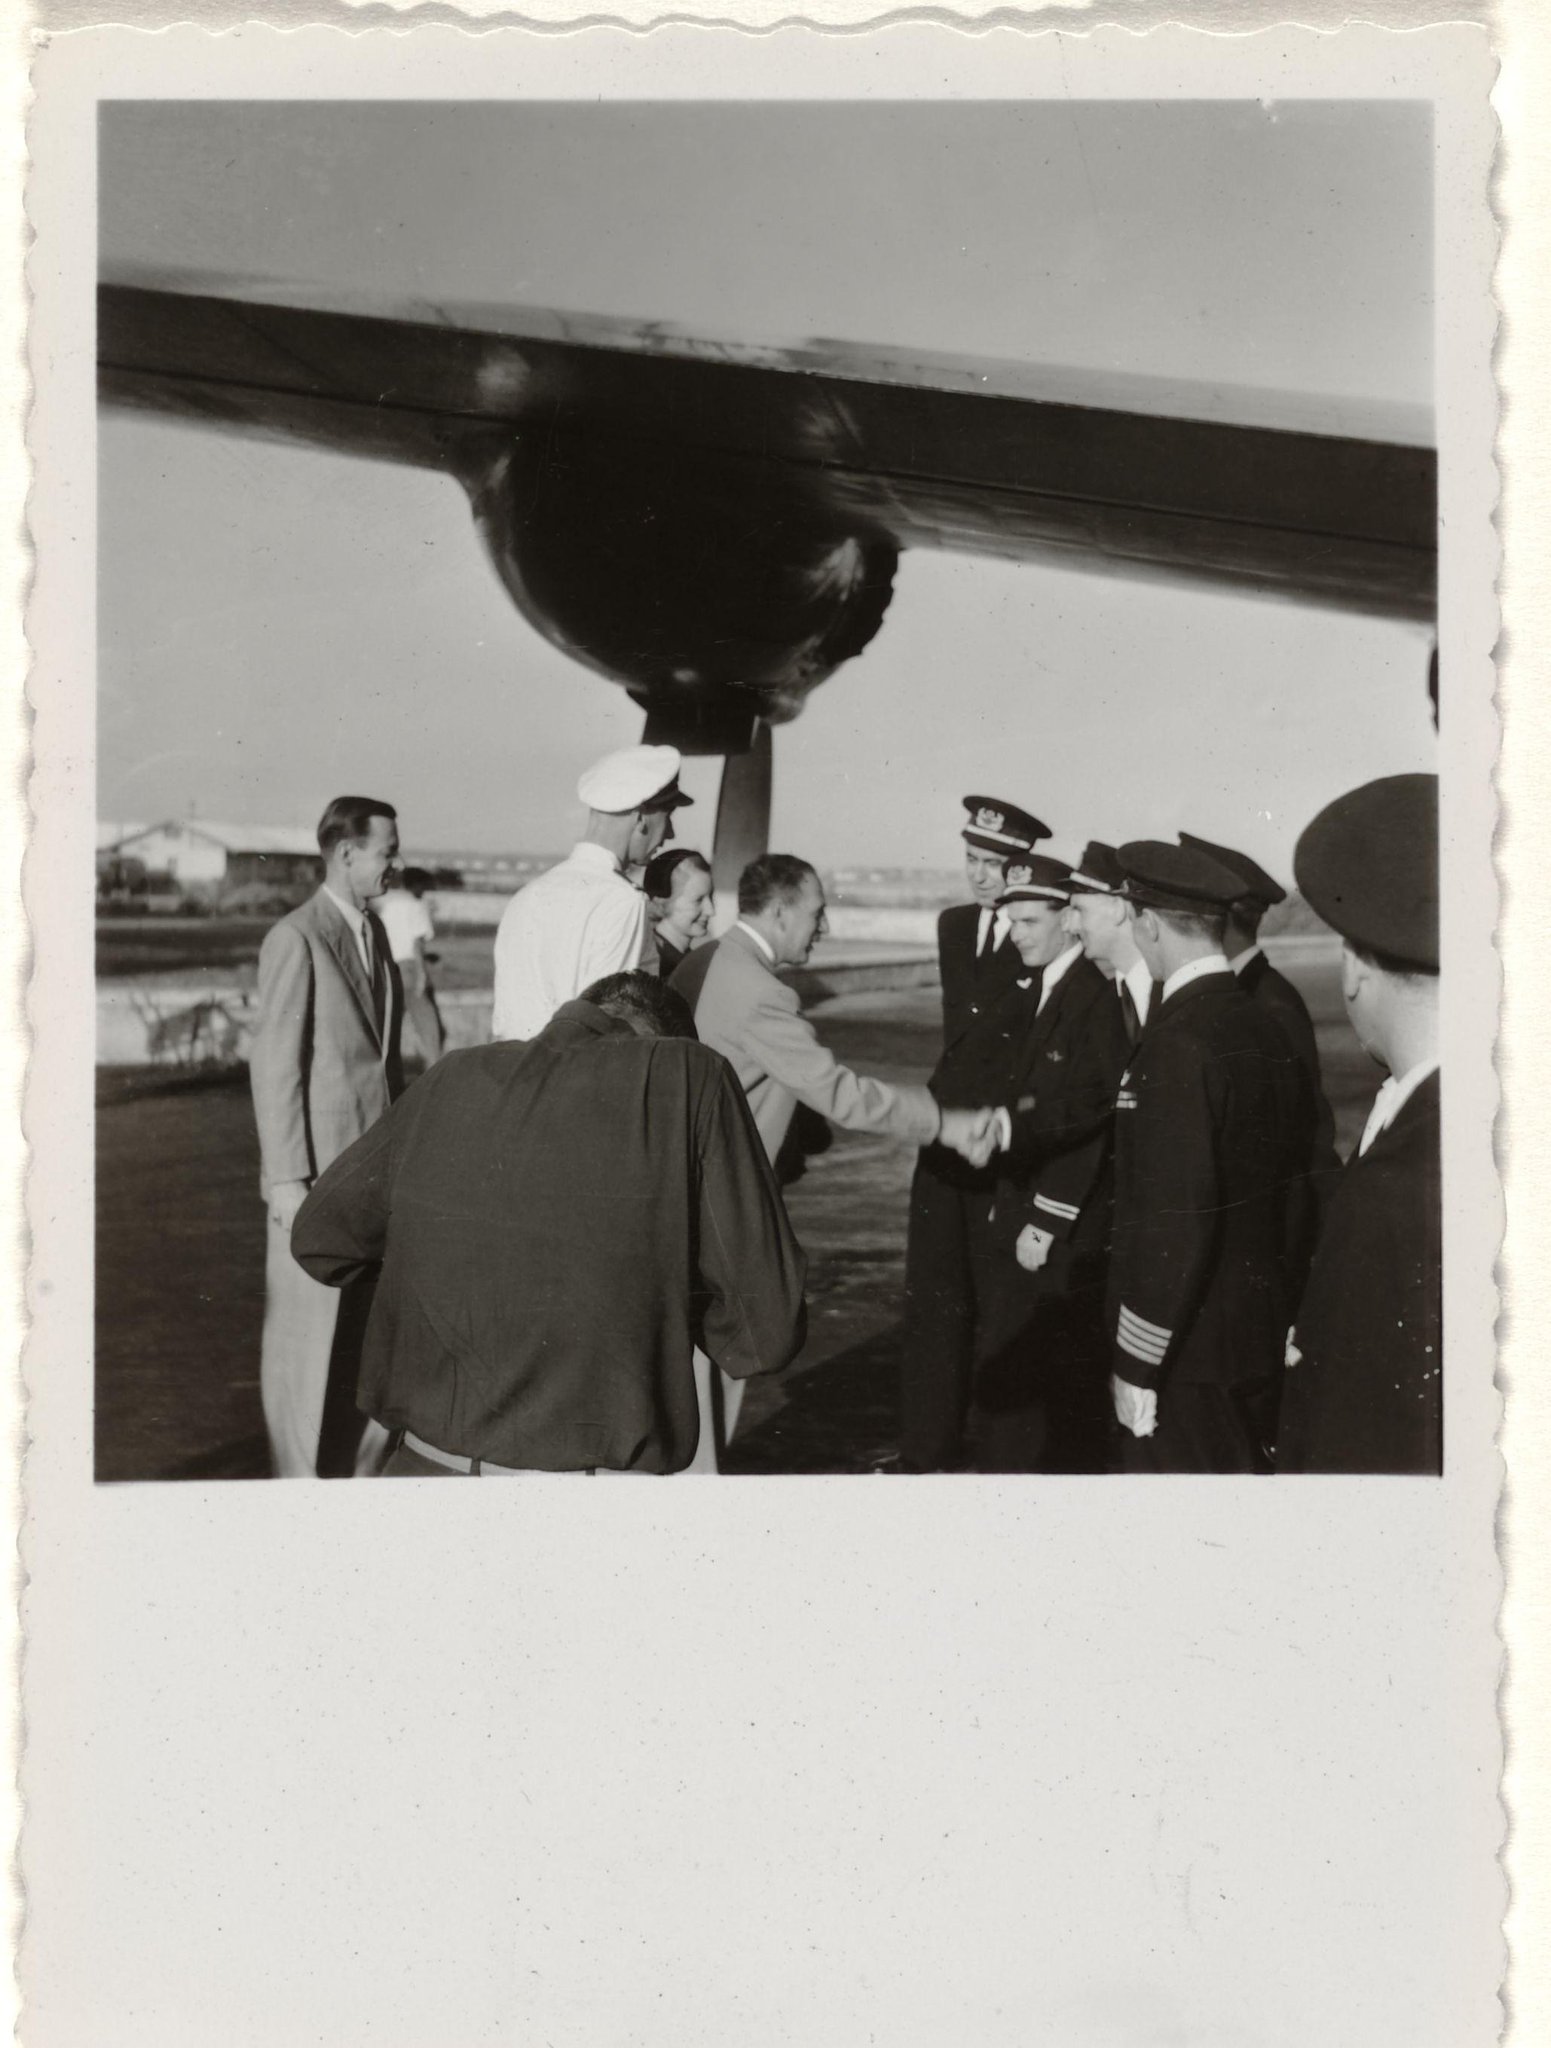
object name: photograph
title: Grondpersoneel begroet een man in een donkerlicht pak voor een vliegtuig, met een fotograaf op de voorgrond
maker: Anonymous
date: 1950-1970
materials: photographic support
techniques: gelatin silver print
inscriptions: number: ‘9’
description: Grondpersoneel begroet een man in een donkerlicht pak voor een vliegtuig, met een fotograaf op de voorgrond.